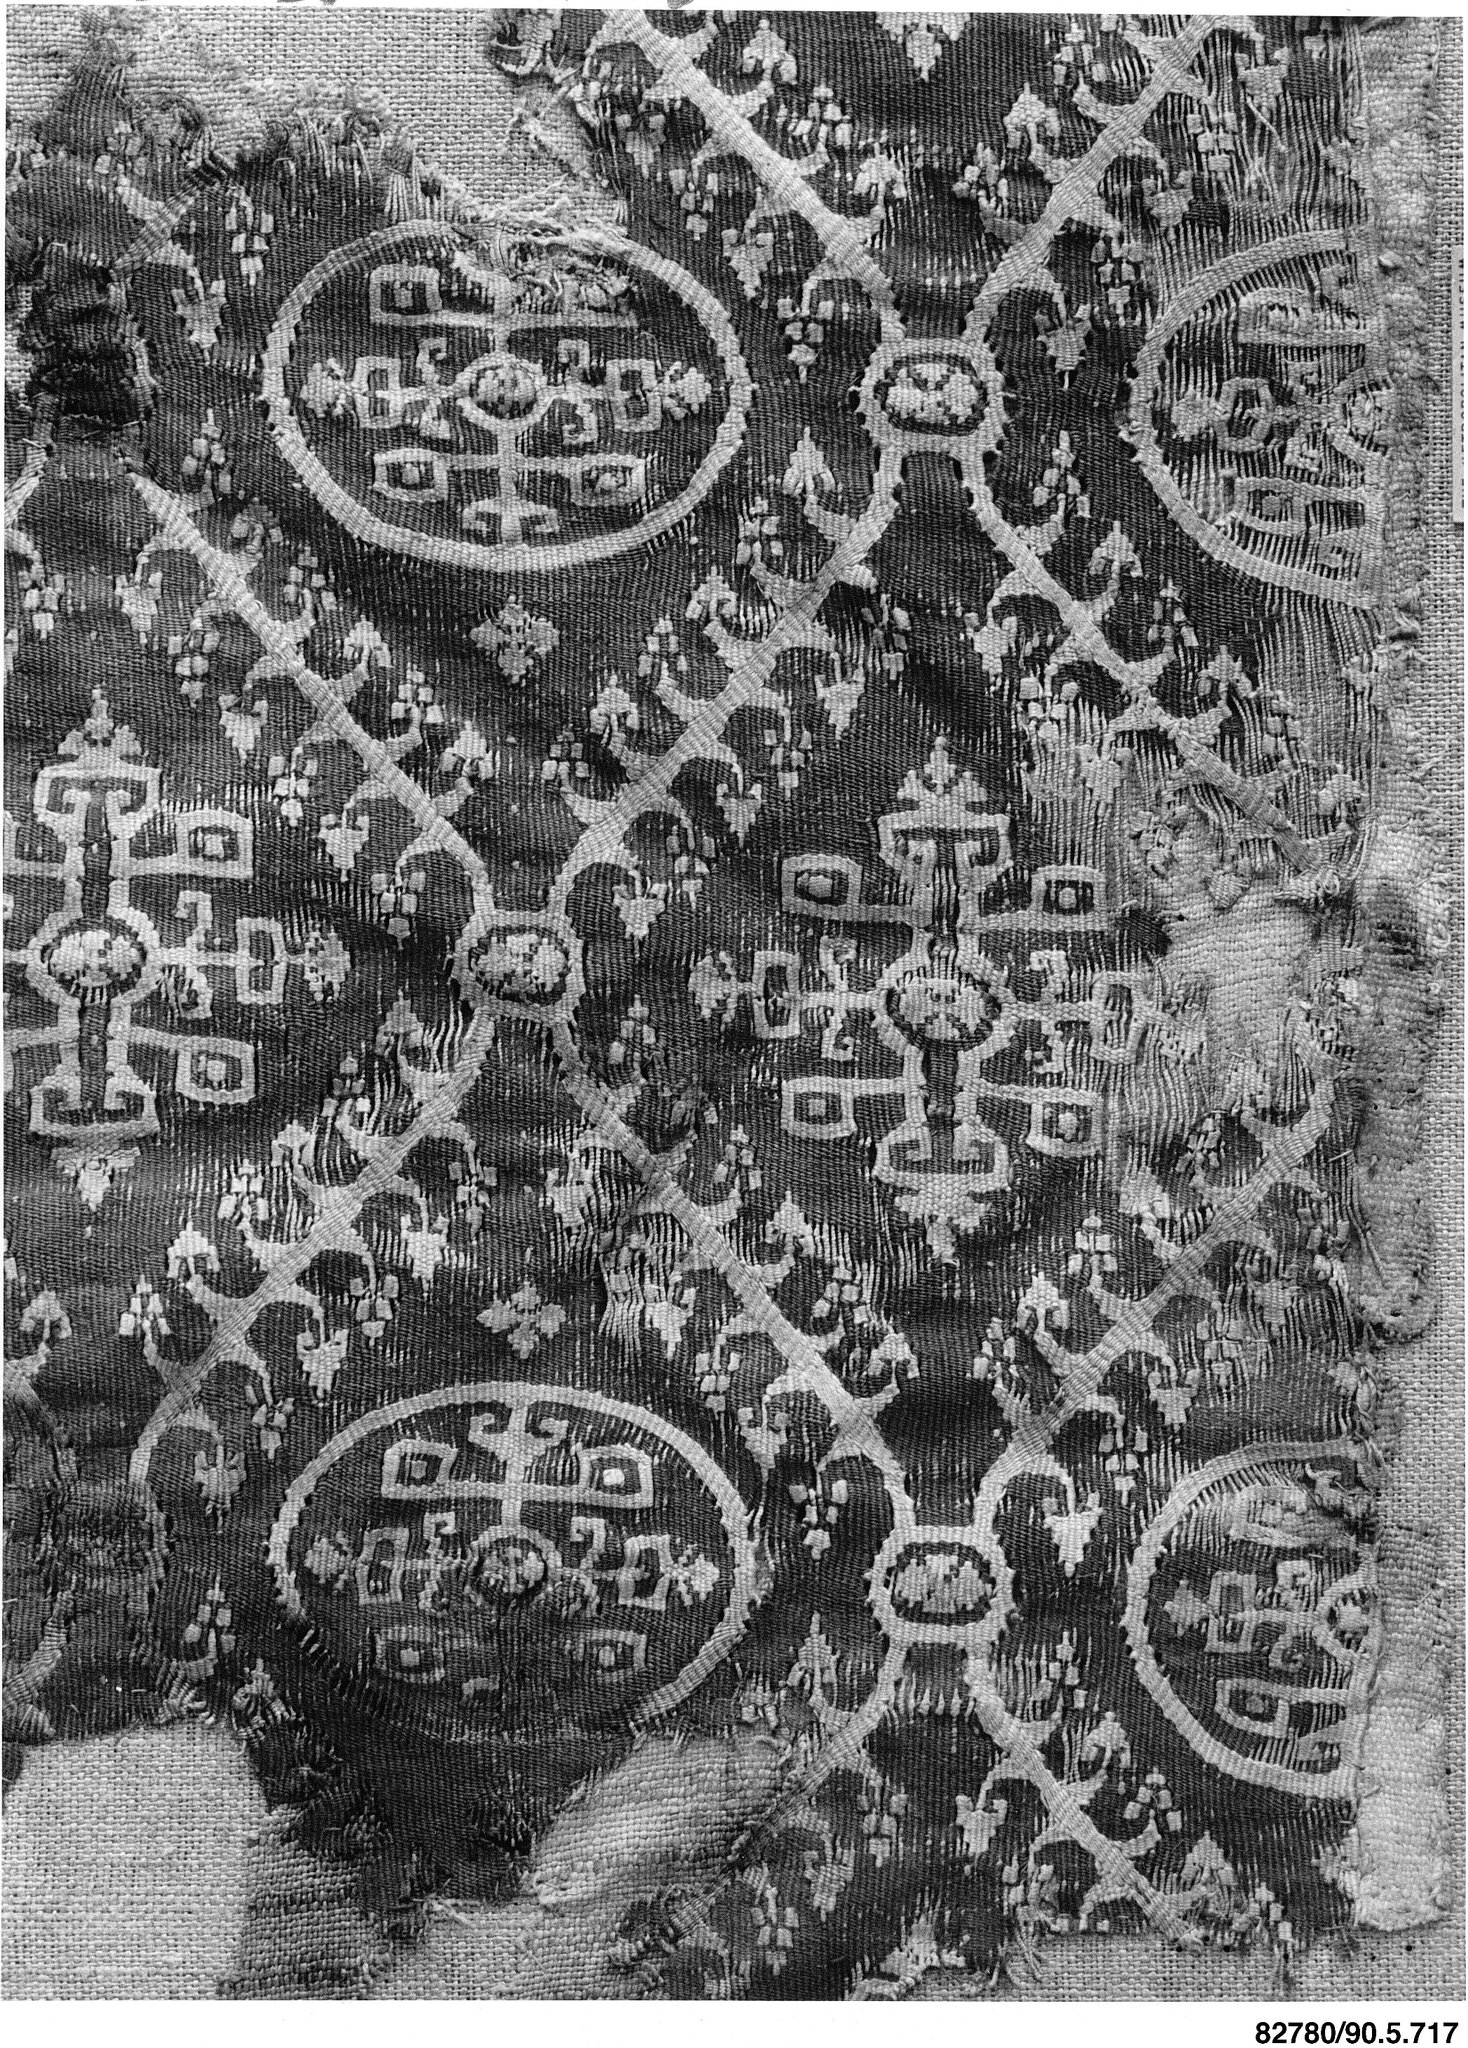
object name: textile fragment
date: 401-600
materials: linen, wool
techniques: weave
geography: egypt